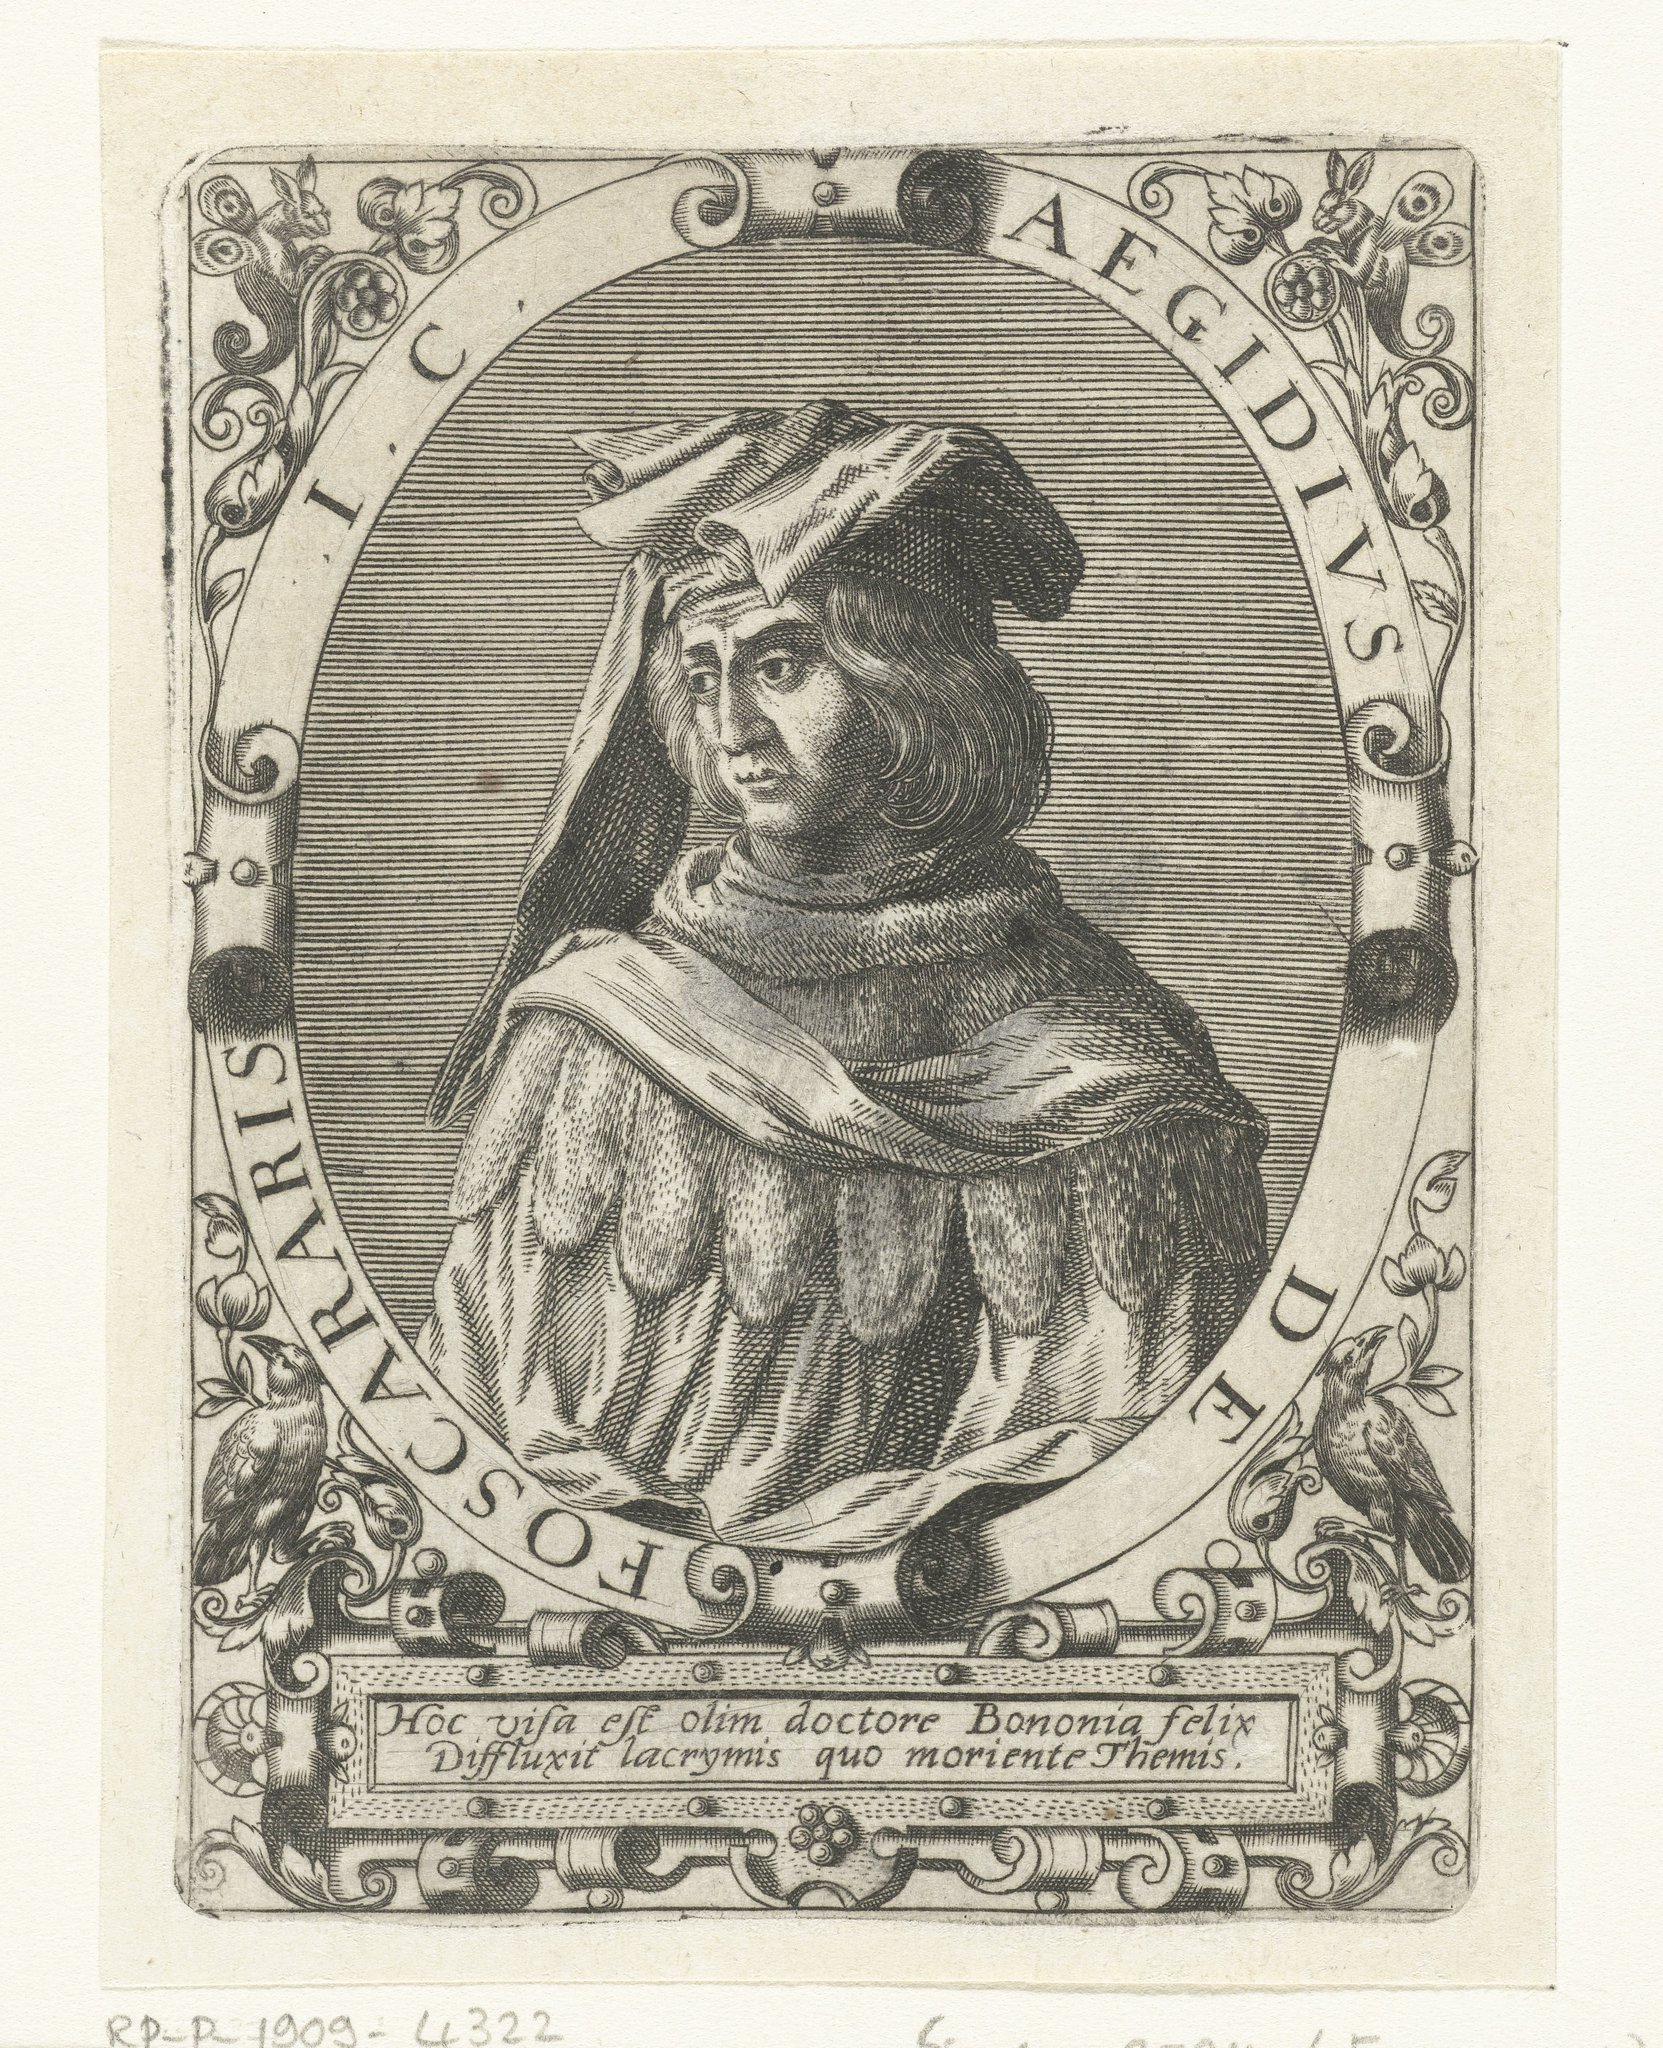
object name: book illustration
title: Aegidius de Foscararis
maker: jean jacques boissard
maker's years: 1528-1598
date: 1597-1599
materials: paper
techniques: engraving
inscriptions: collector's mark: Lugt 2228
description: Gemaakt voor: J.J. Boissard, Icones virorum illustrium doctrina &c eruditione praestanti um contines. Frankfurt am Main: de Bry, 1597-1599.